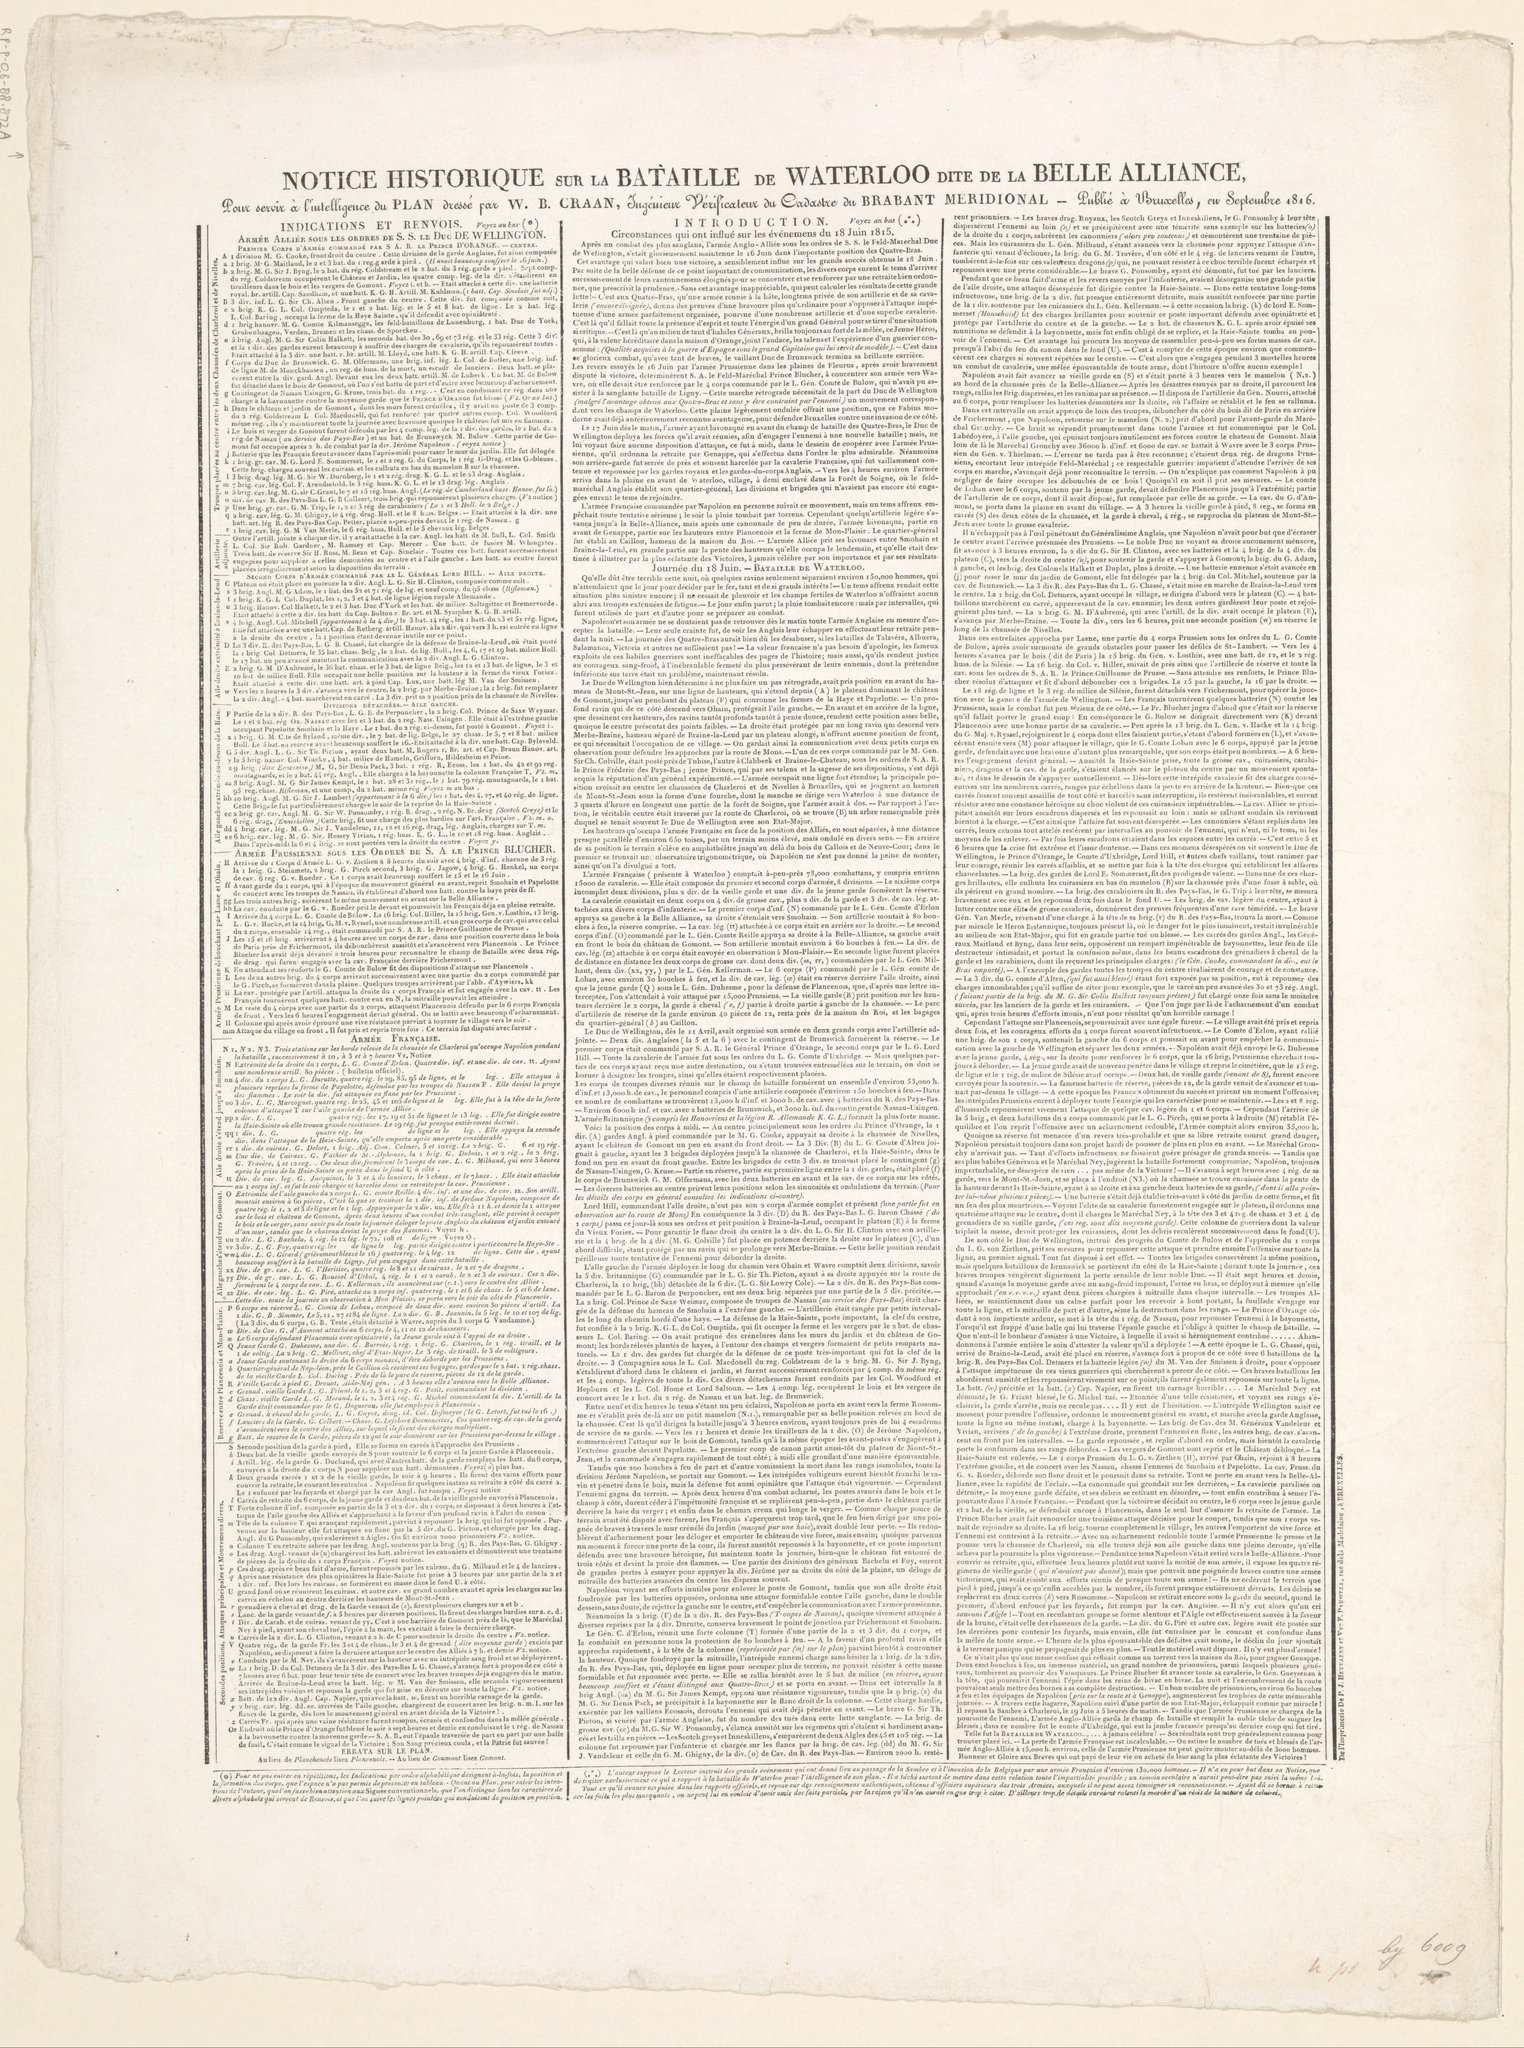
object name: text sheet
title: Verklaring bij de kaart van de Slag bij Waterloo, 1815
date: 1809-1816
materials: paper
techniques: letterpress printing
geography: brussels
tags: waterloo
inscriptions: collector's mark: Lugt 2228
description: Tekstblad met een gedrukte verklaring van de kaart en beschrijving van de Slag bij Waterloo op 18 juni 1815. Tekst in het Frans in drie kolommen.